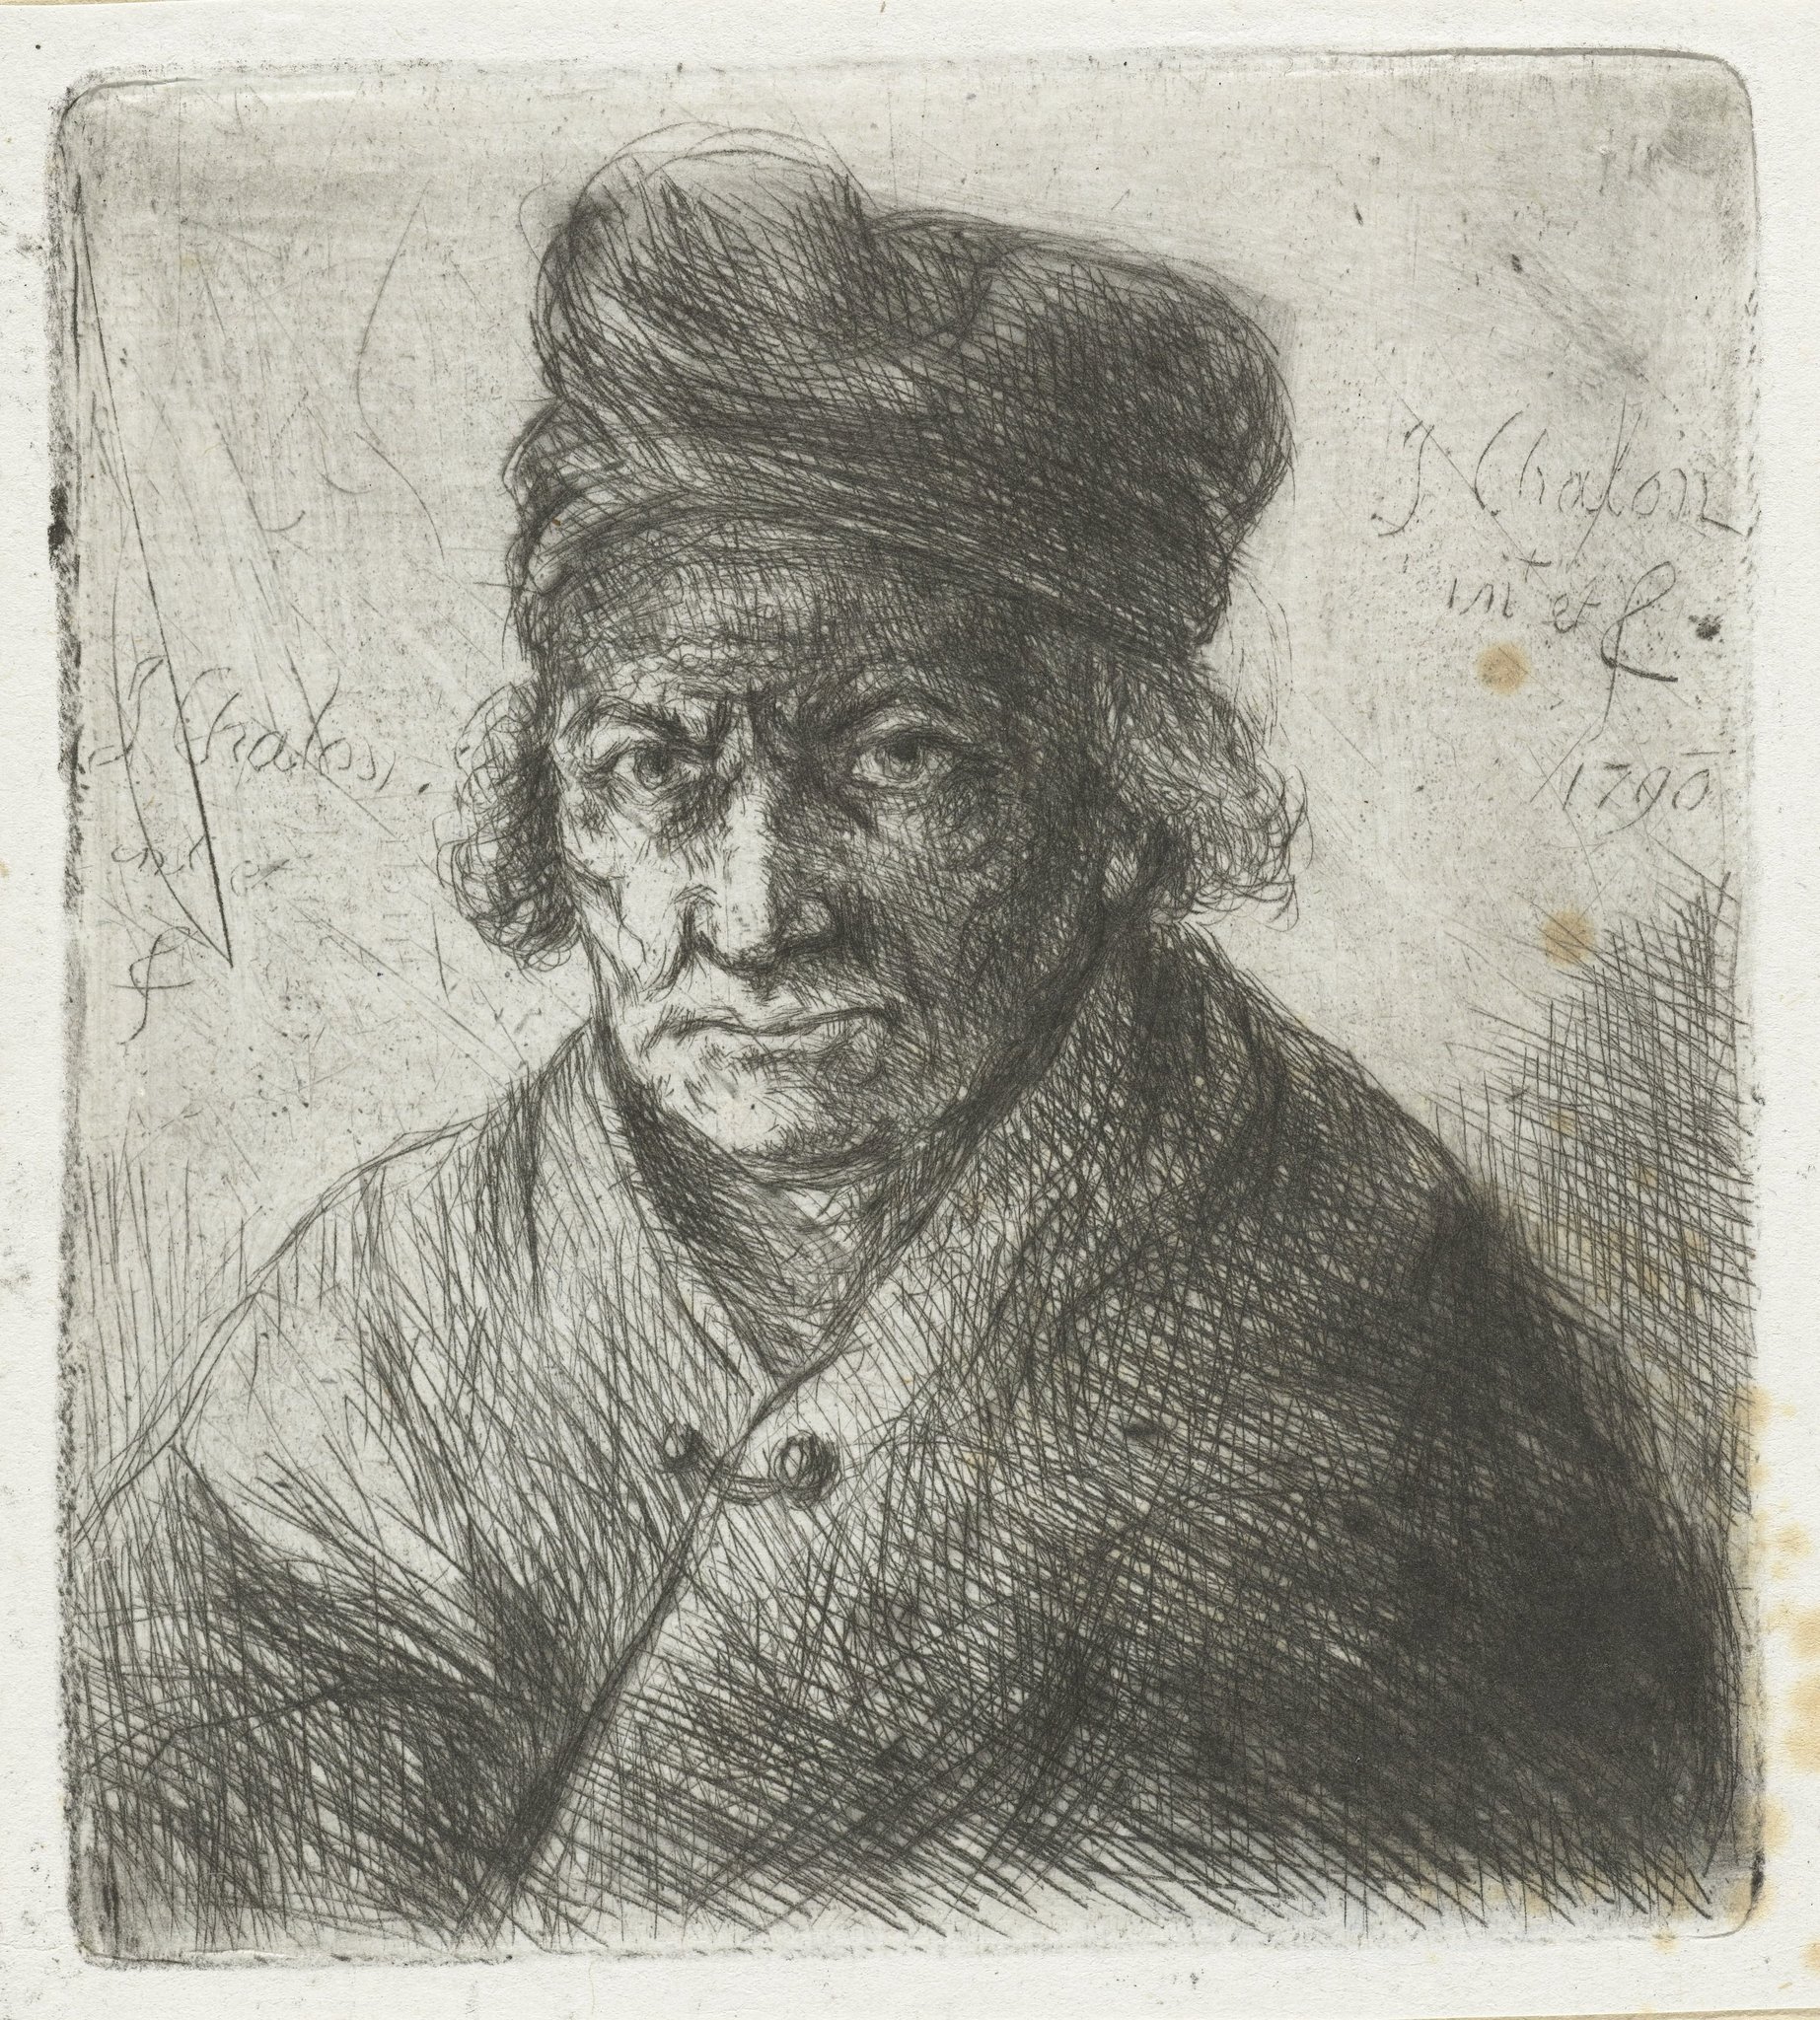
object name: print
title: Man met muts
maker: jan chalon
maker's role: print maker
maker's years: 1738-1795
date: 1790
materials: paper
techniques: drypoint, etching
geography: northern netherlands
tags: head-gear: cap (+ men's clothes), morphology of human expression (+ old male (human being))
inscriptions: collector's mark: Lugt 924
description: Een oude man met muts. Buste licht naar links.